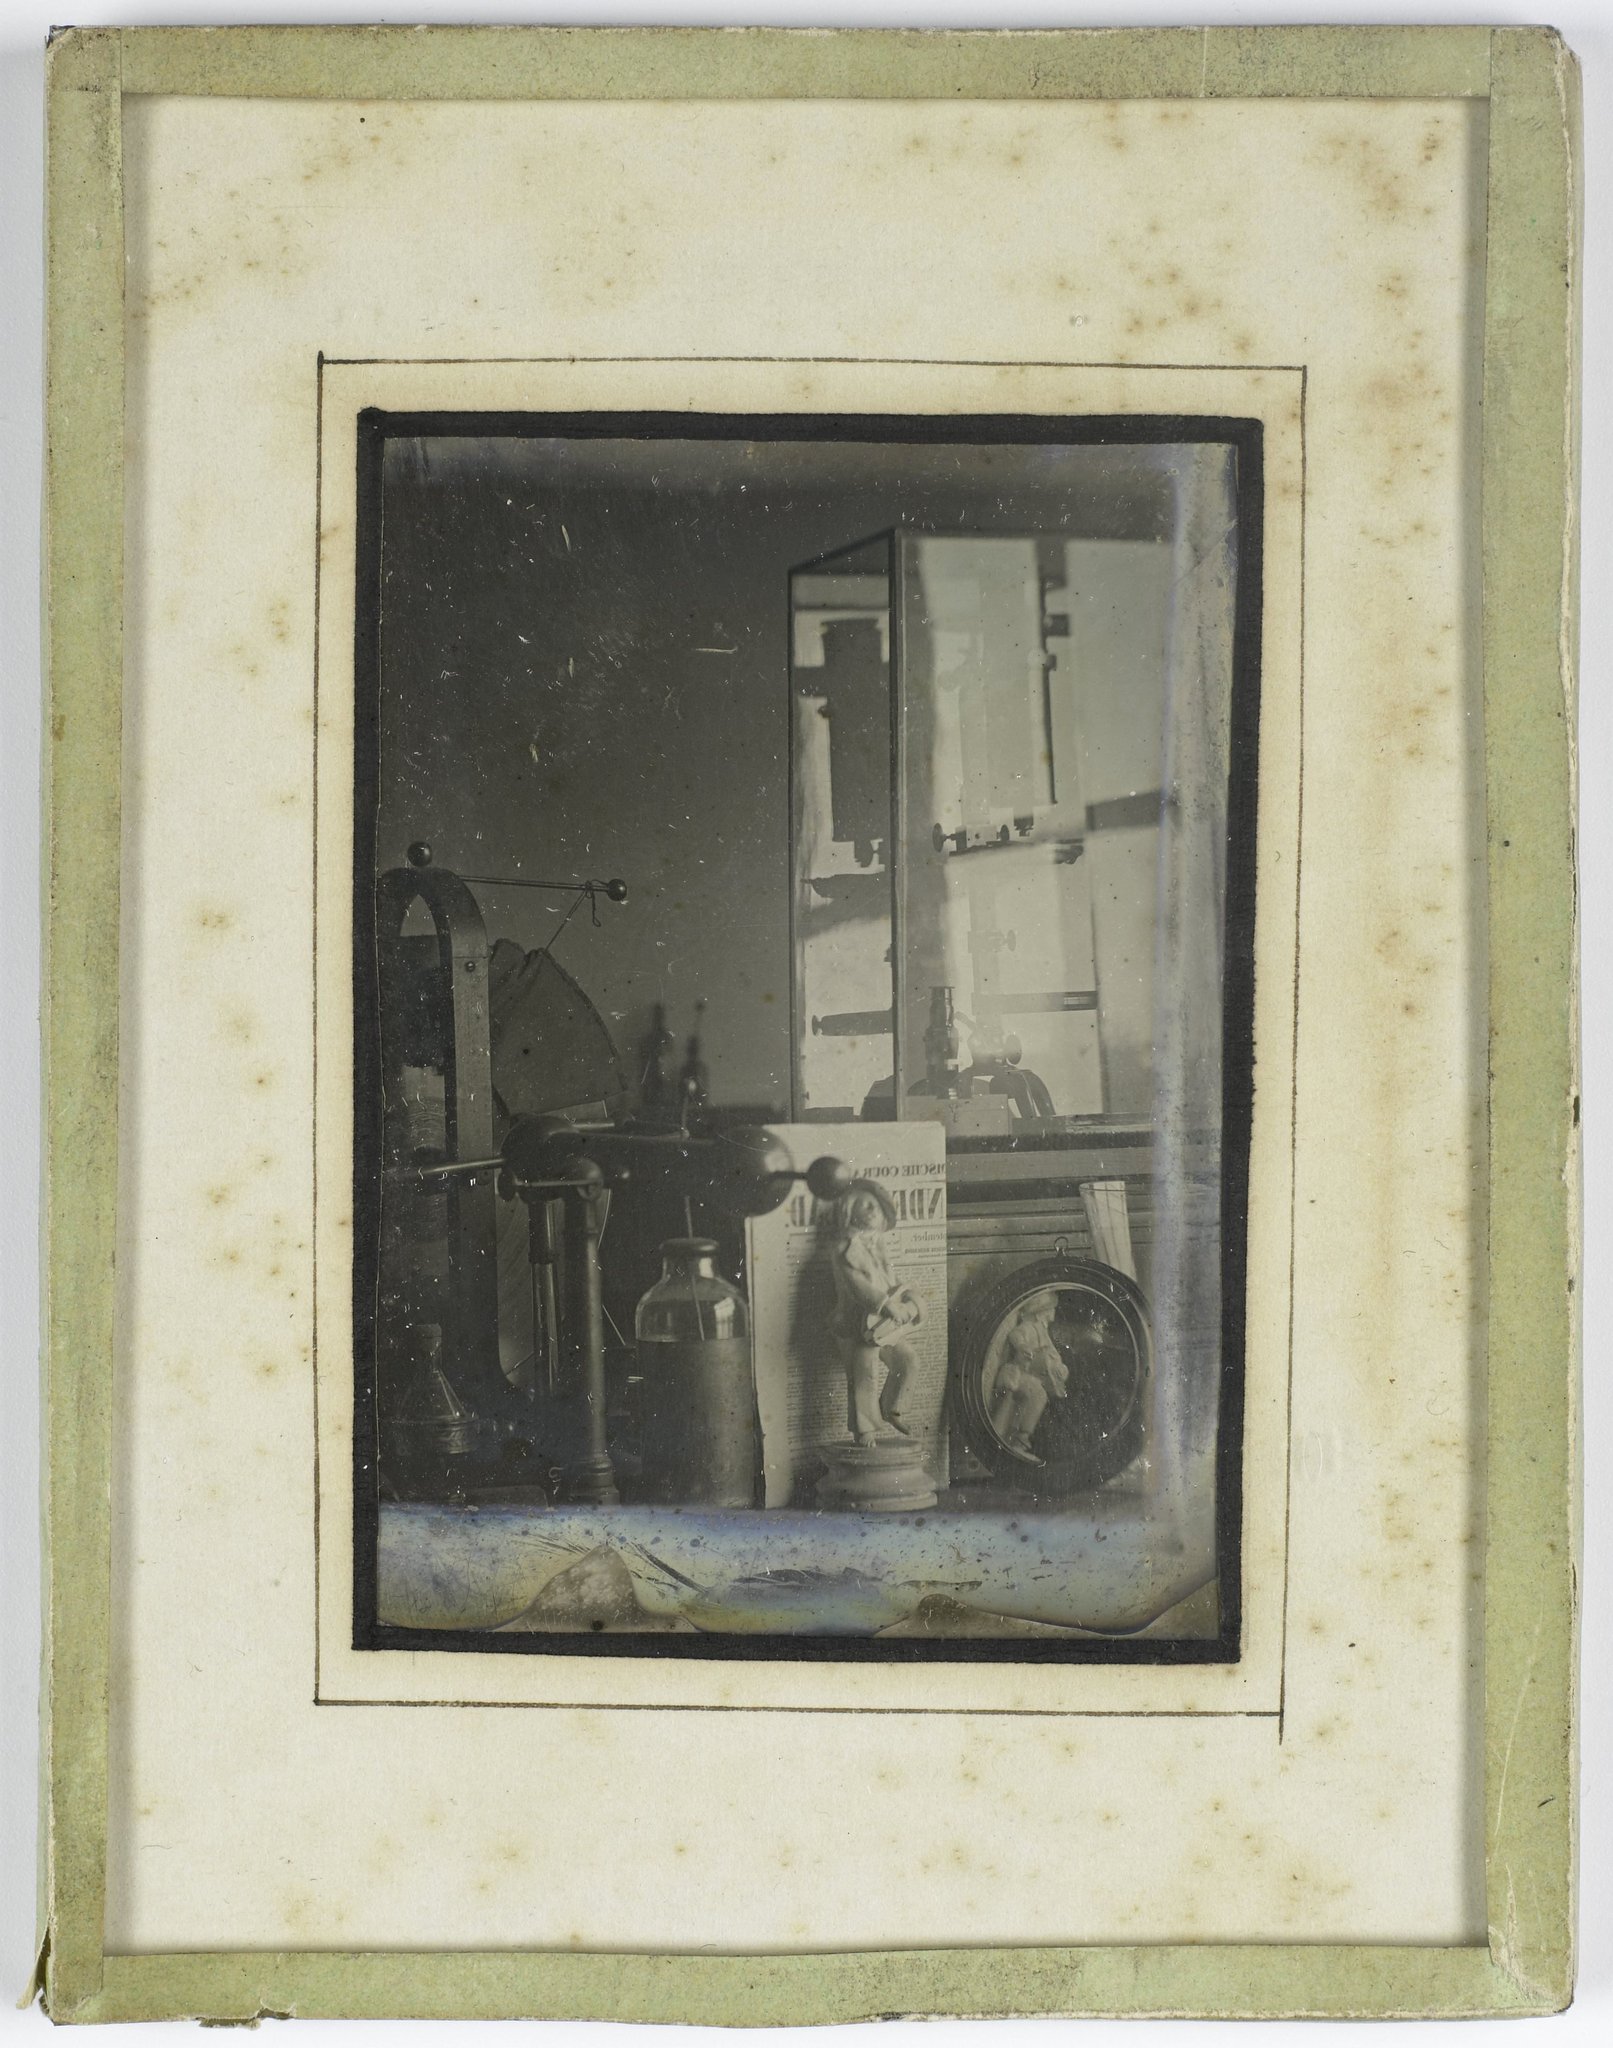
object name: photograph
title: Stilleven met Algemeen Handelsblad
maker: Anonymous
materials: copper, glass, paper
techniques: daguerreotype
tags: container of glass: bottle, jar, vase, newspaper, news-sheet, still life of miscellaneous objects